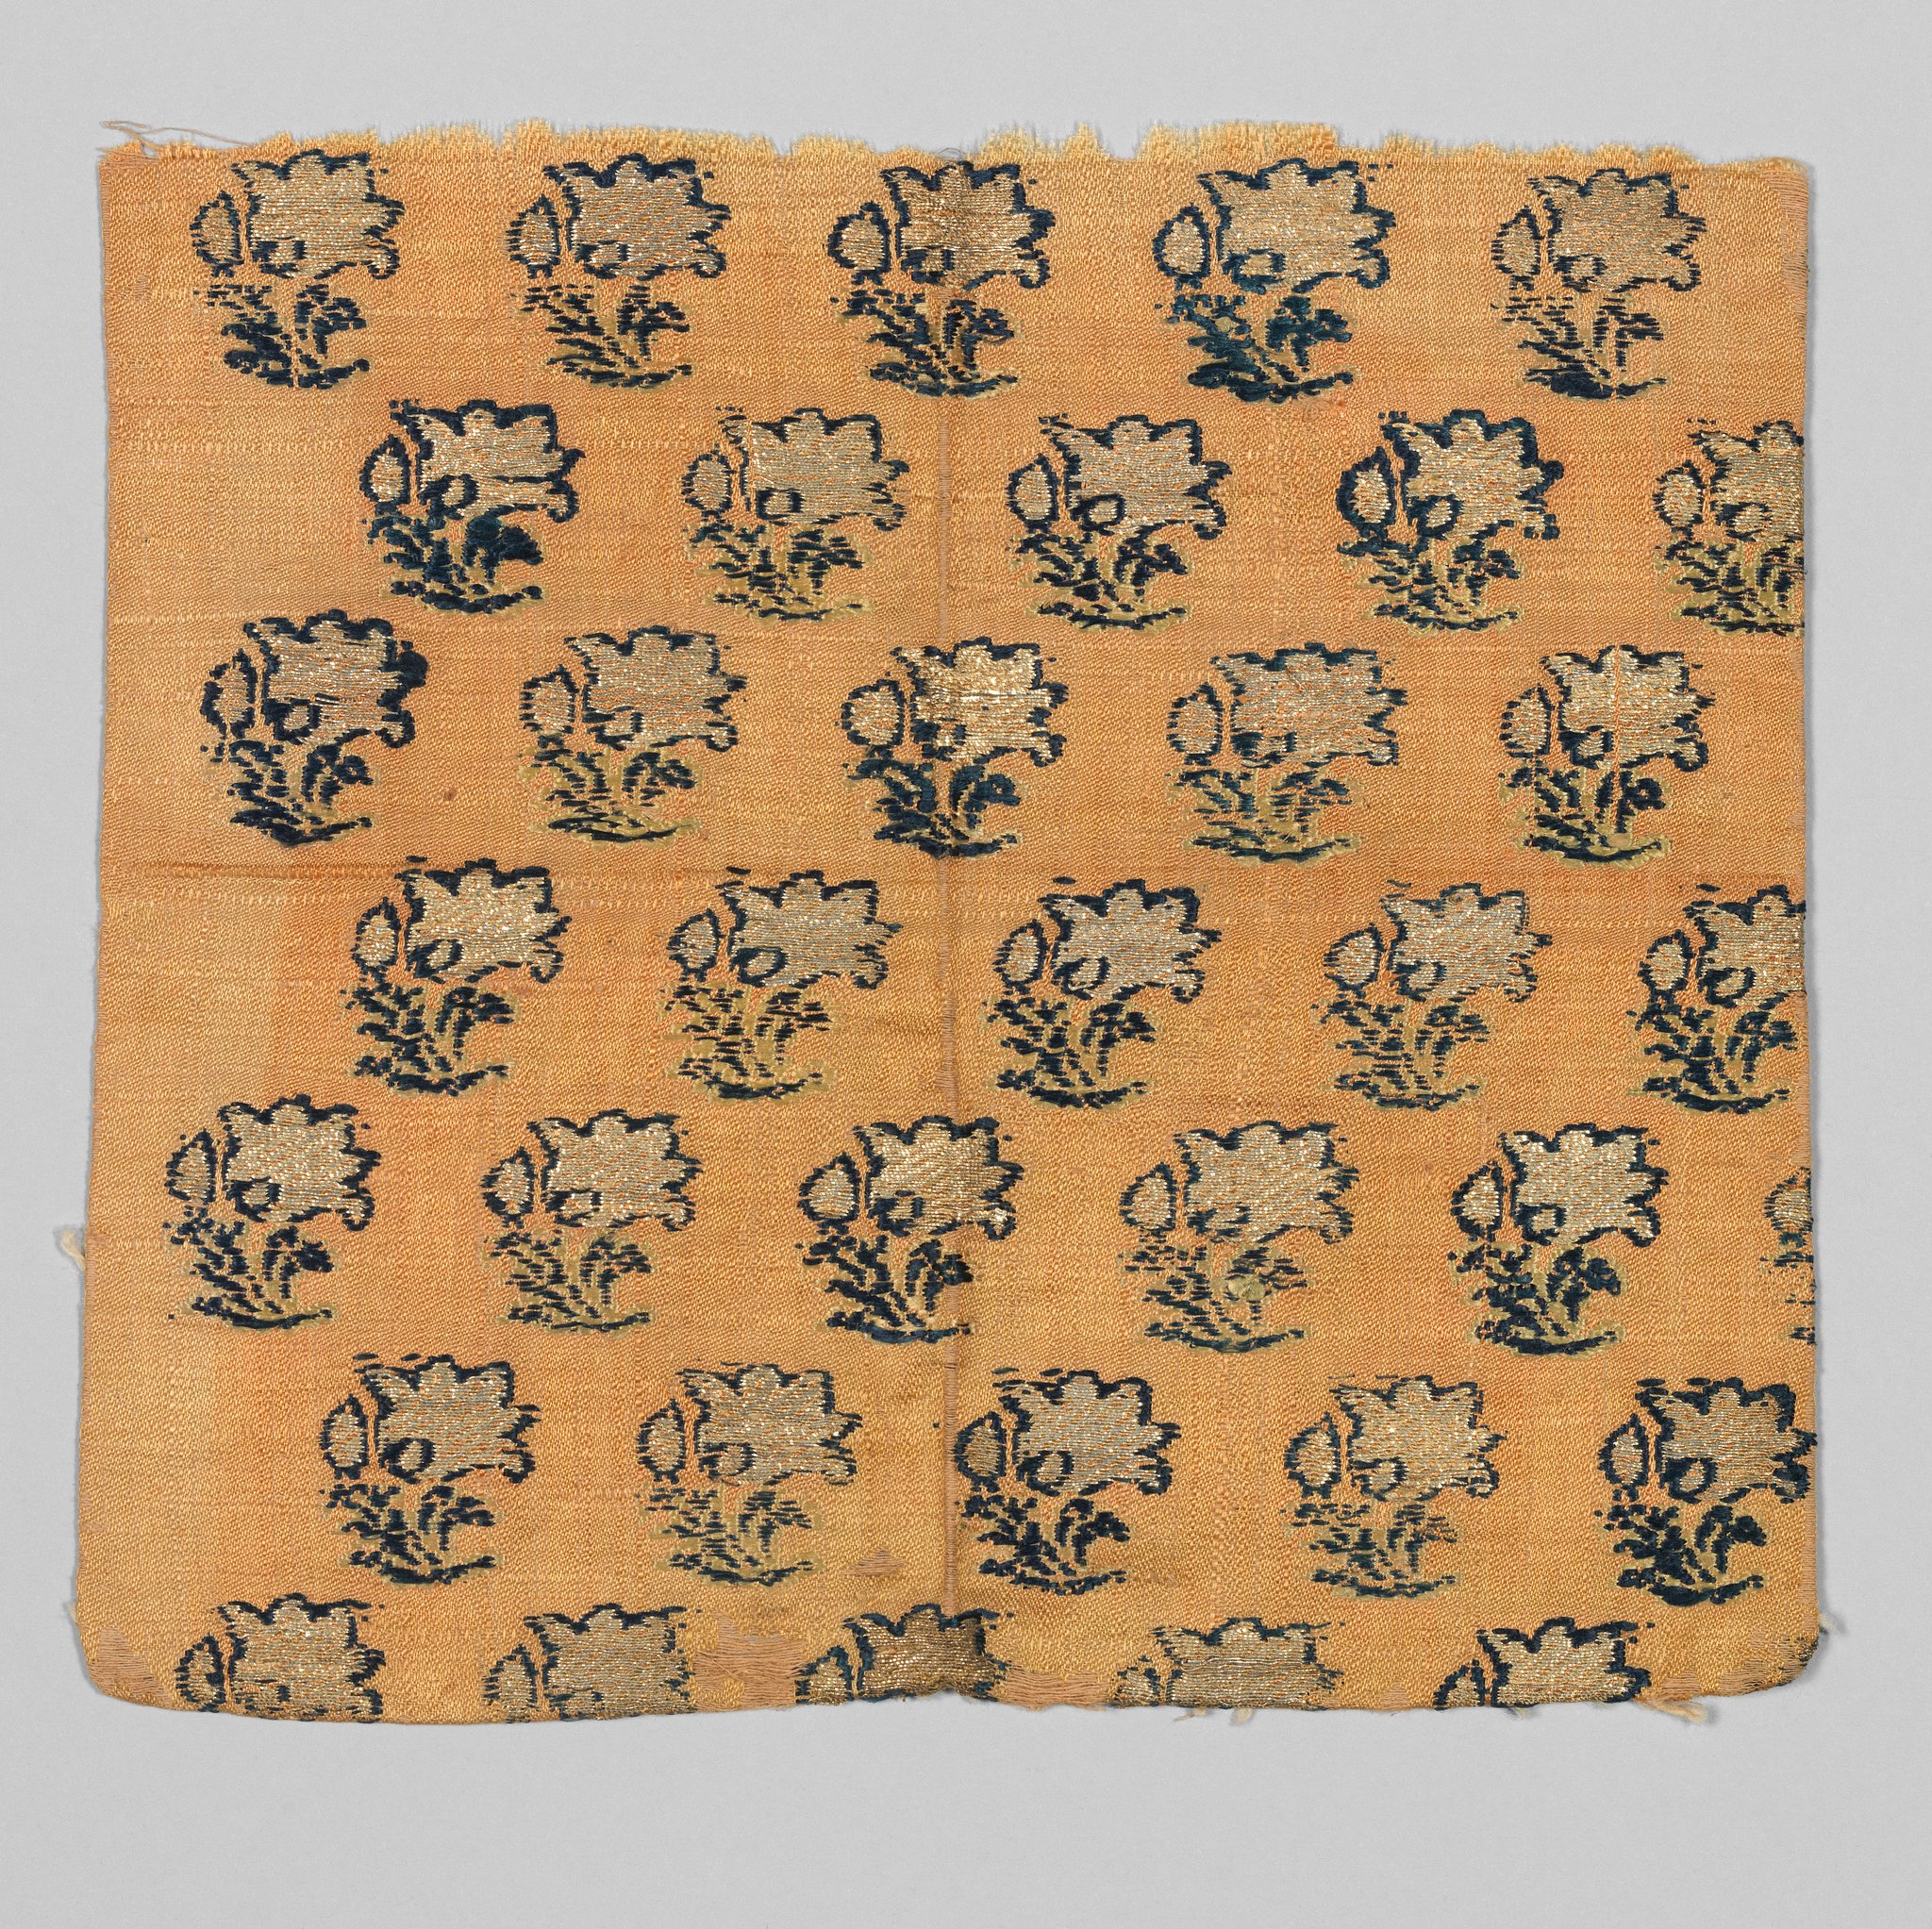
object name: textile fragment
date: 1701-1800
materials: metal thread, silk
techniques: brocade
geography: india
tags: flowers